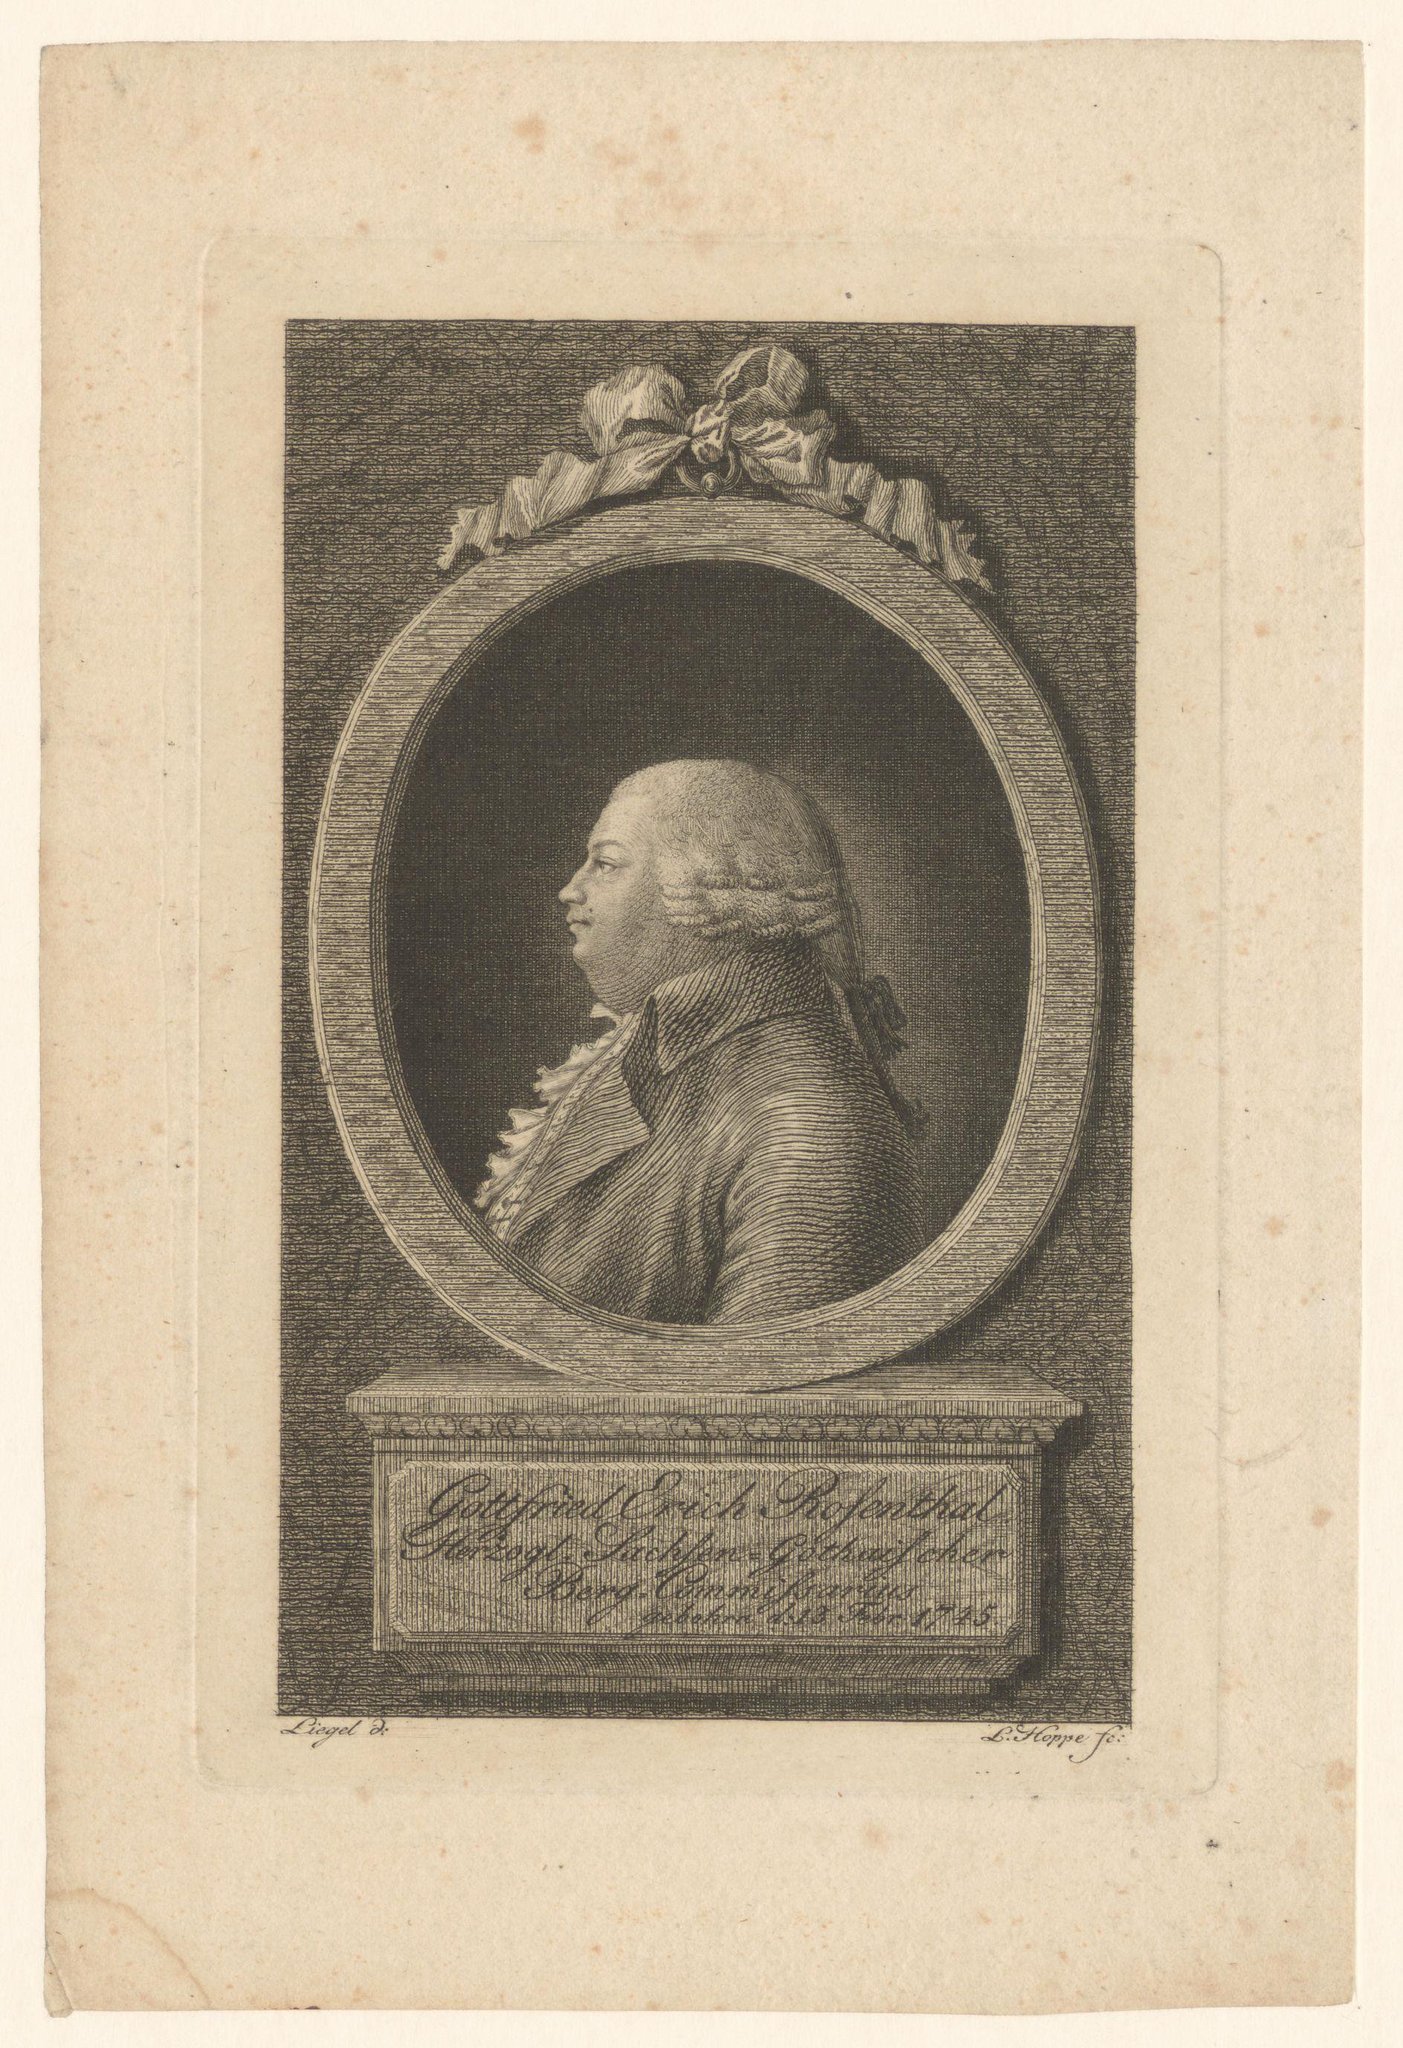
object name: print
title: Portret van Erich Gottfried Rosenthal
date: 1755-1813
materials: paper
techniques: engraving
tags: historical persons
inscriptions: collector's mark: Lugt 2228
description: Portret van Erich Gottfried Rosenthal en profil naar links in een ovale medaillon. Tekst in het Duits onderaan.